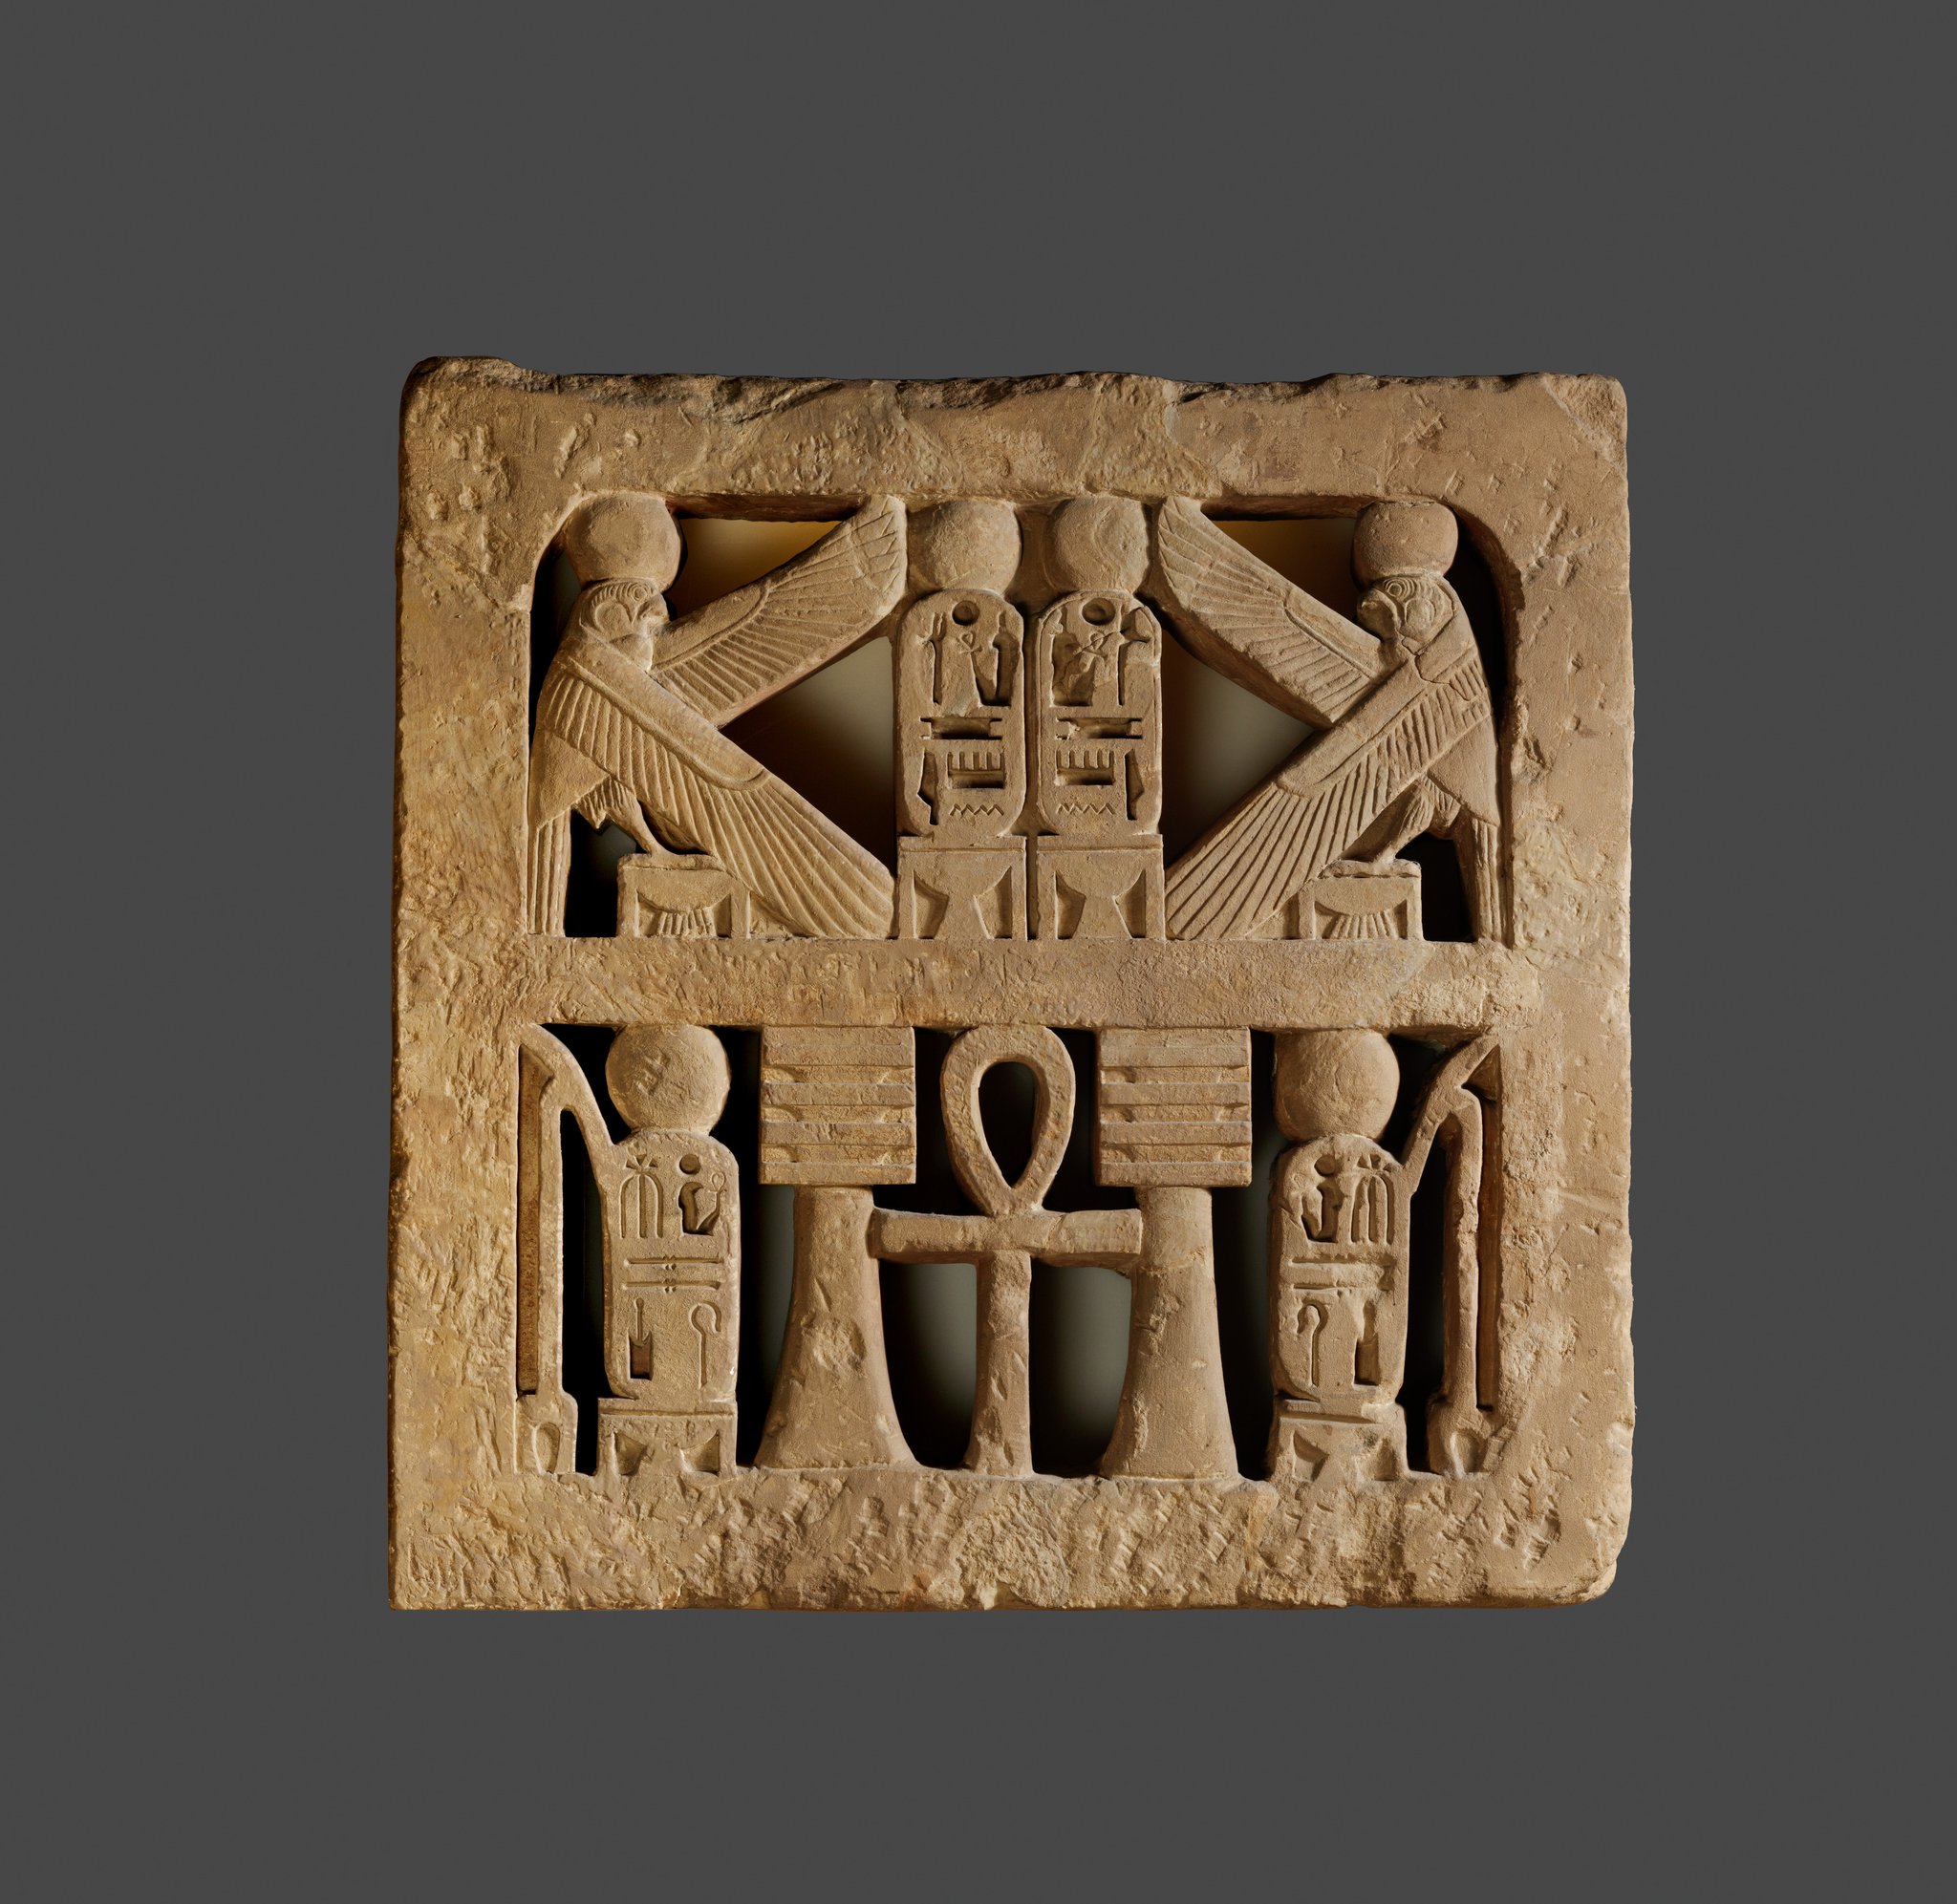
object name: window grill, palace of ramesses iii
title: Window grill from a palace of Ramesses III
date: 1184-1153 BCE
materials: paint, stone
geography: egypt